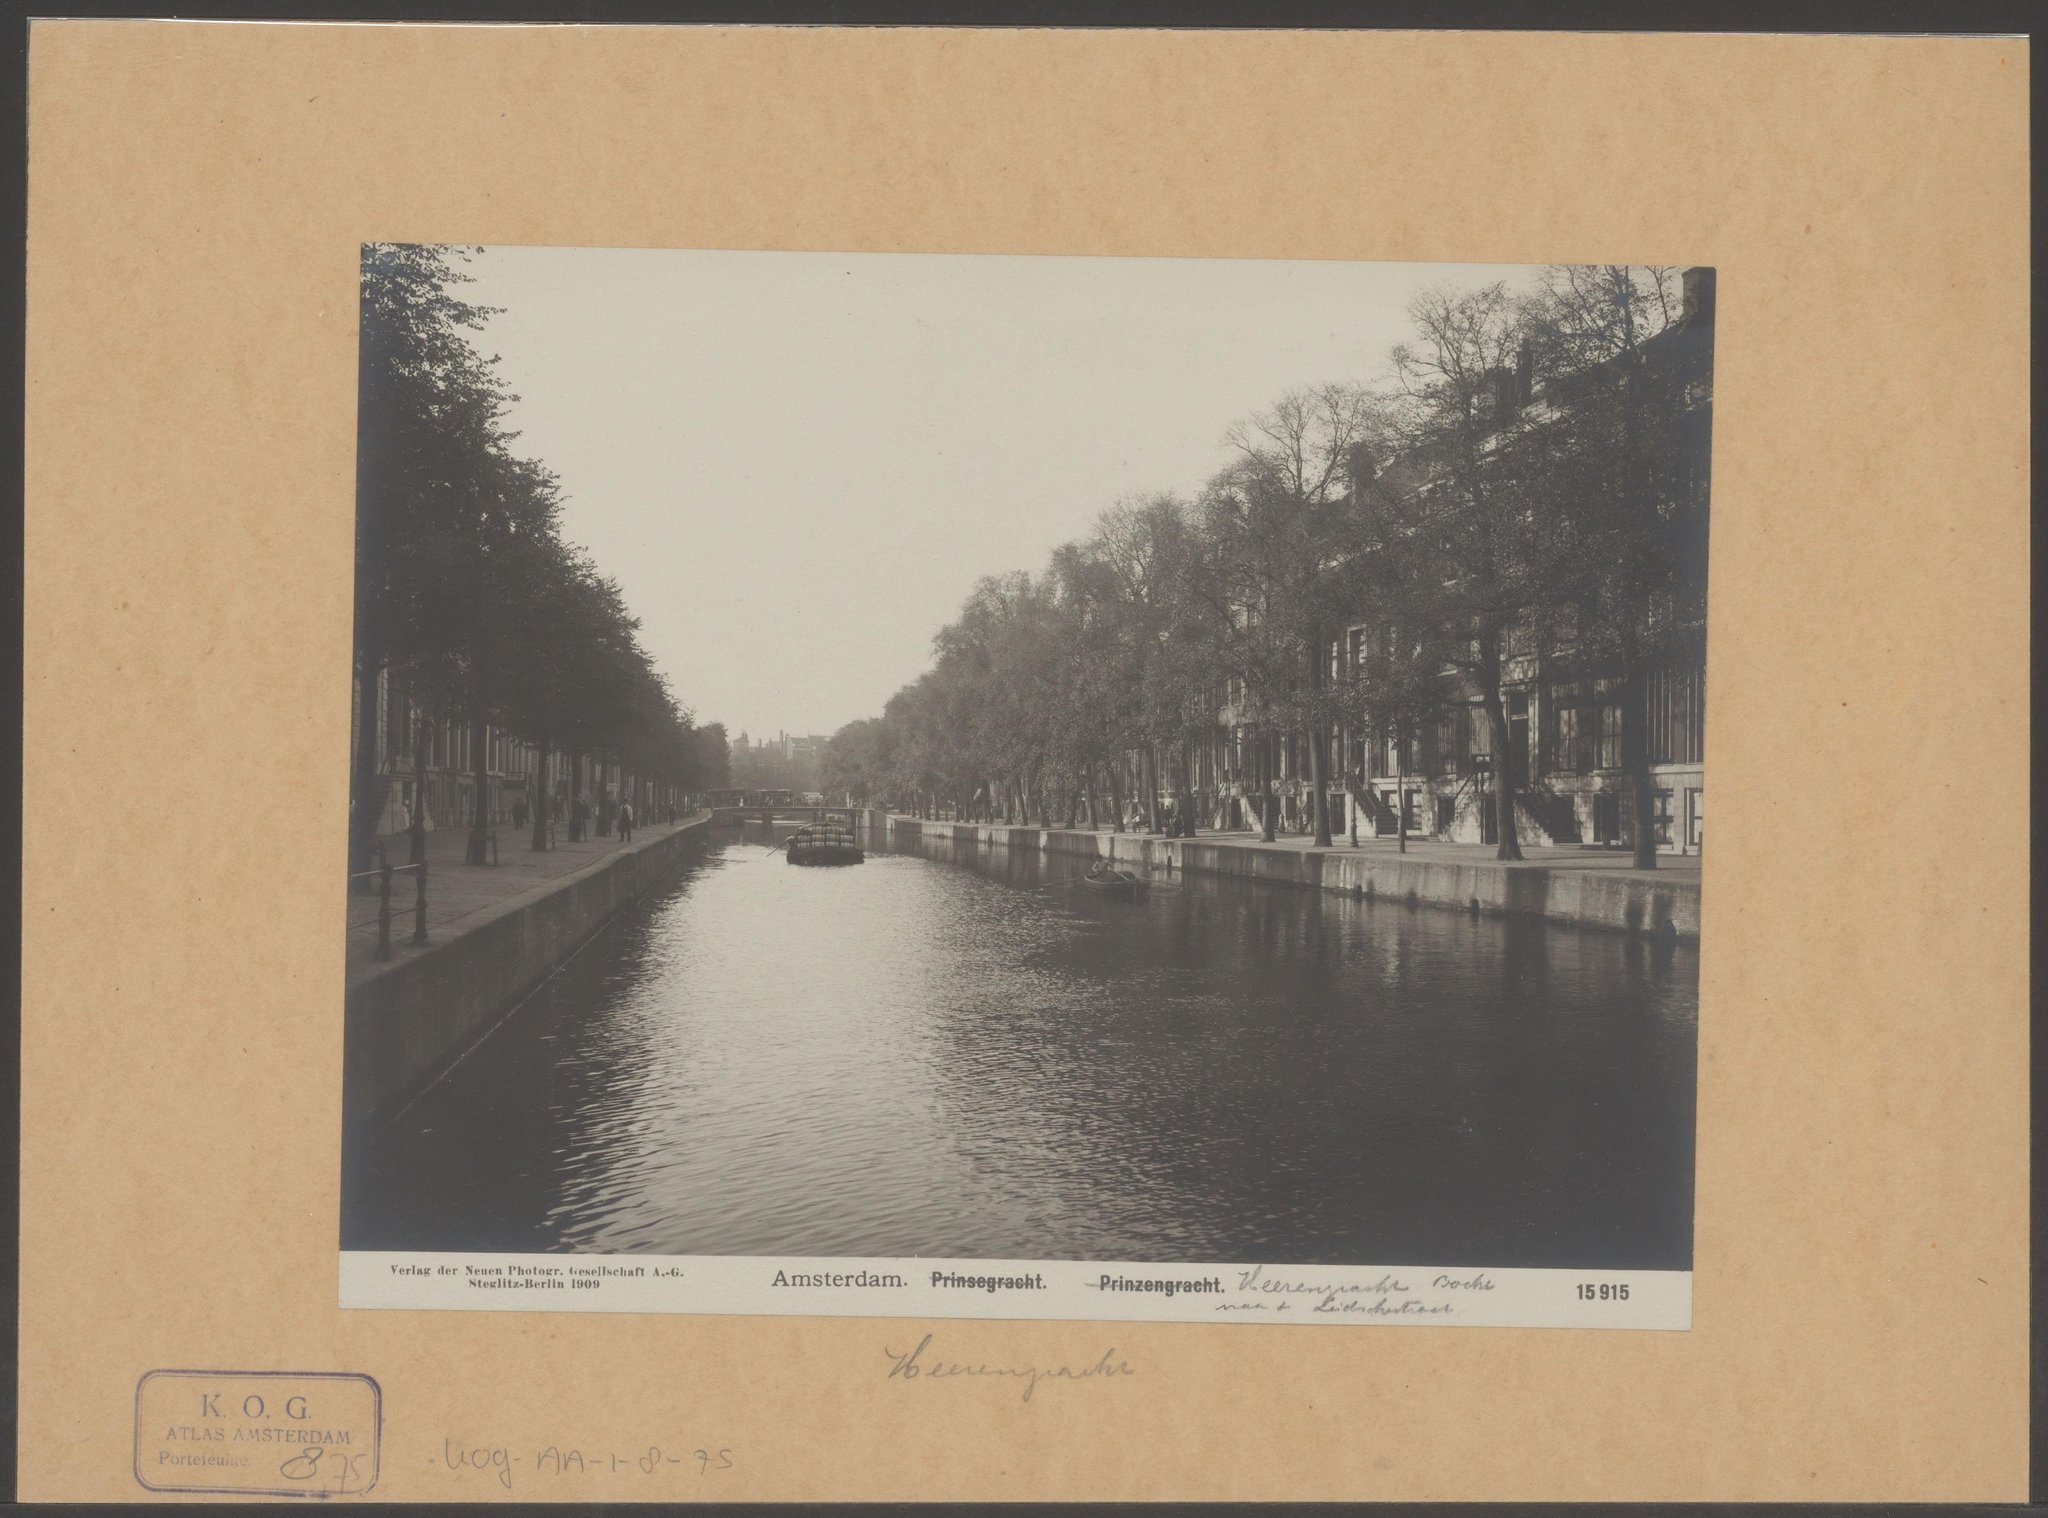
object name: photograph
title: Gezicht op de Herengracht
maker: Anonymous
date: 1909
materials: paper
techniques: gelatin silver print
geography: amsterdam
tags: city-view in general; 'veduta', canal, bridge in city across river, canal, etc.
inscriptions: inscription: ‘Heerengracht Bocht / naar de Leidsestraat / Heerengracht’, collector's mark: ‘8,75’ Lugt 1641b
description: Onderwerpsrubriek binnen de Atlas Amsterdam: Haarlemmerplein, Halvemaansteeg, Handboogstraat, Handelskade, Haringpakkerij, Hartenstraat, Hasseltsteeg (Dirk van), Heerengracht.